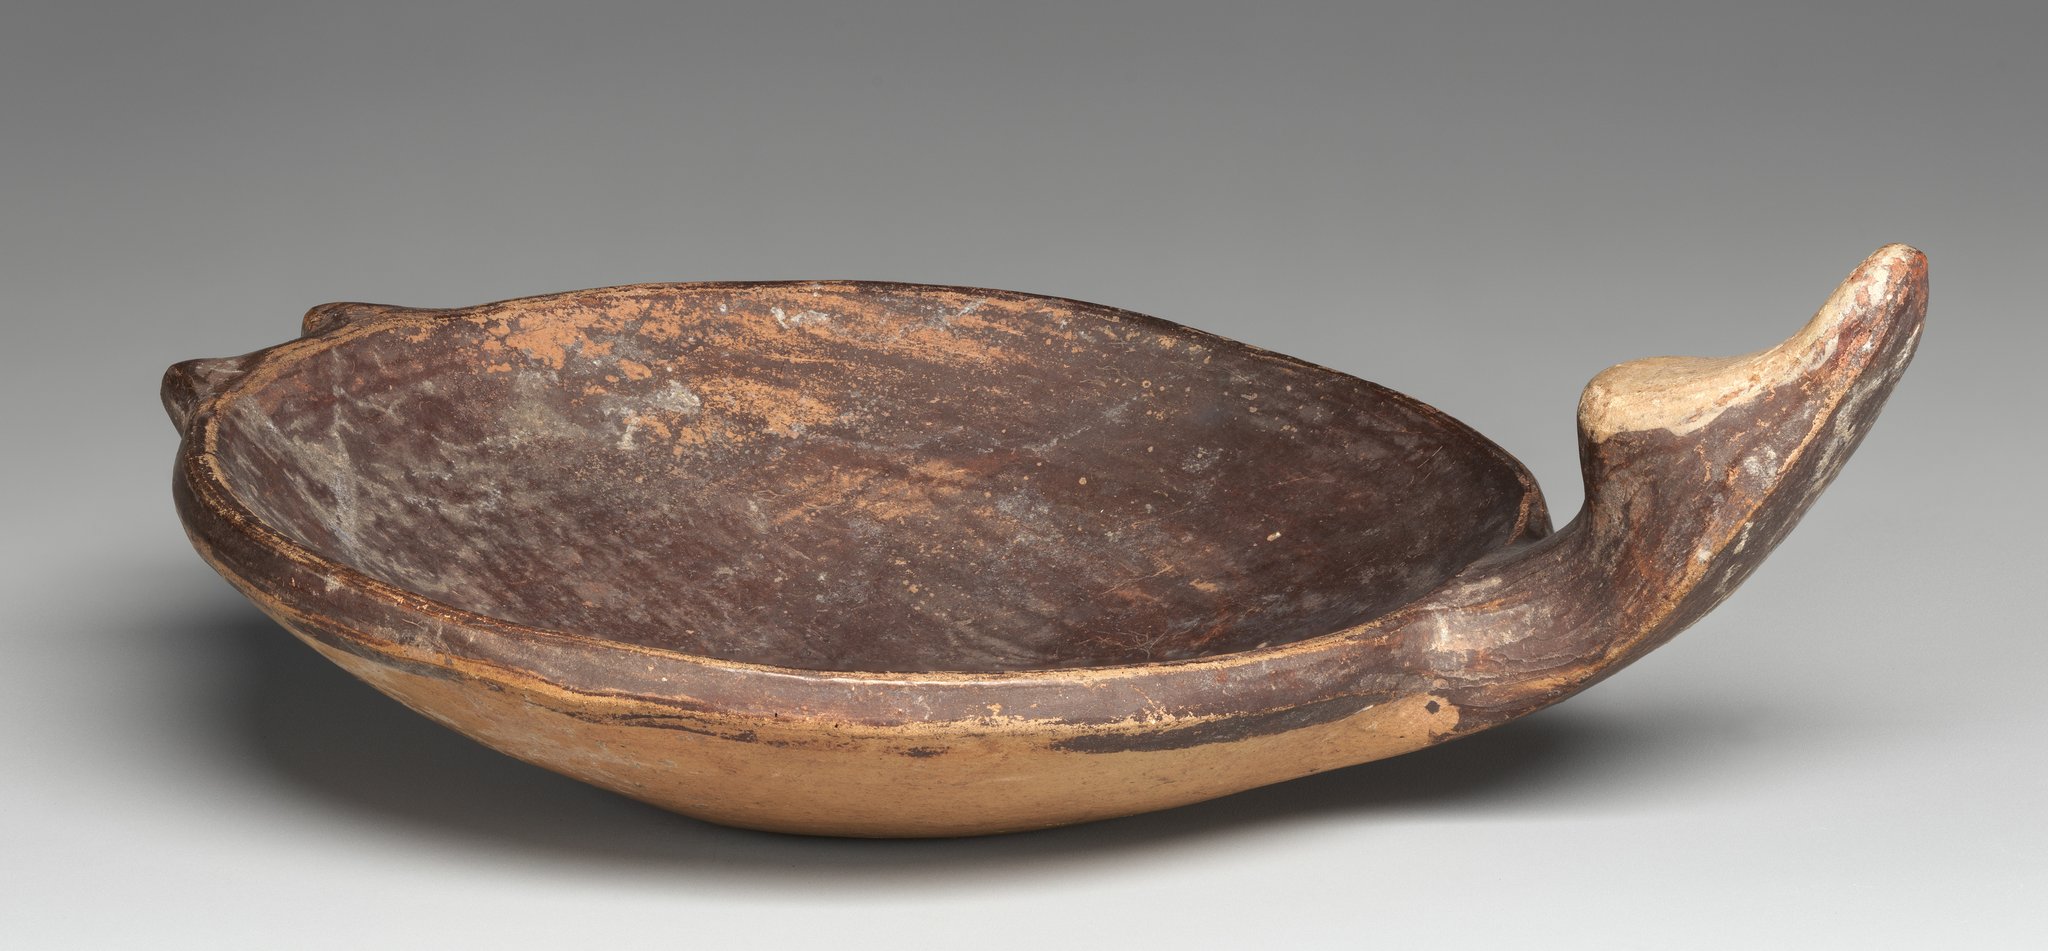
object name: miniature dish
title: Miniature Vessel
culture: inca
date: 1401-1533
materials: ceramic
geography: peru